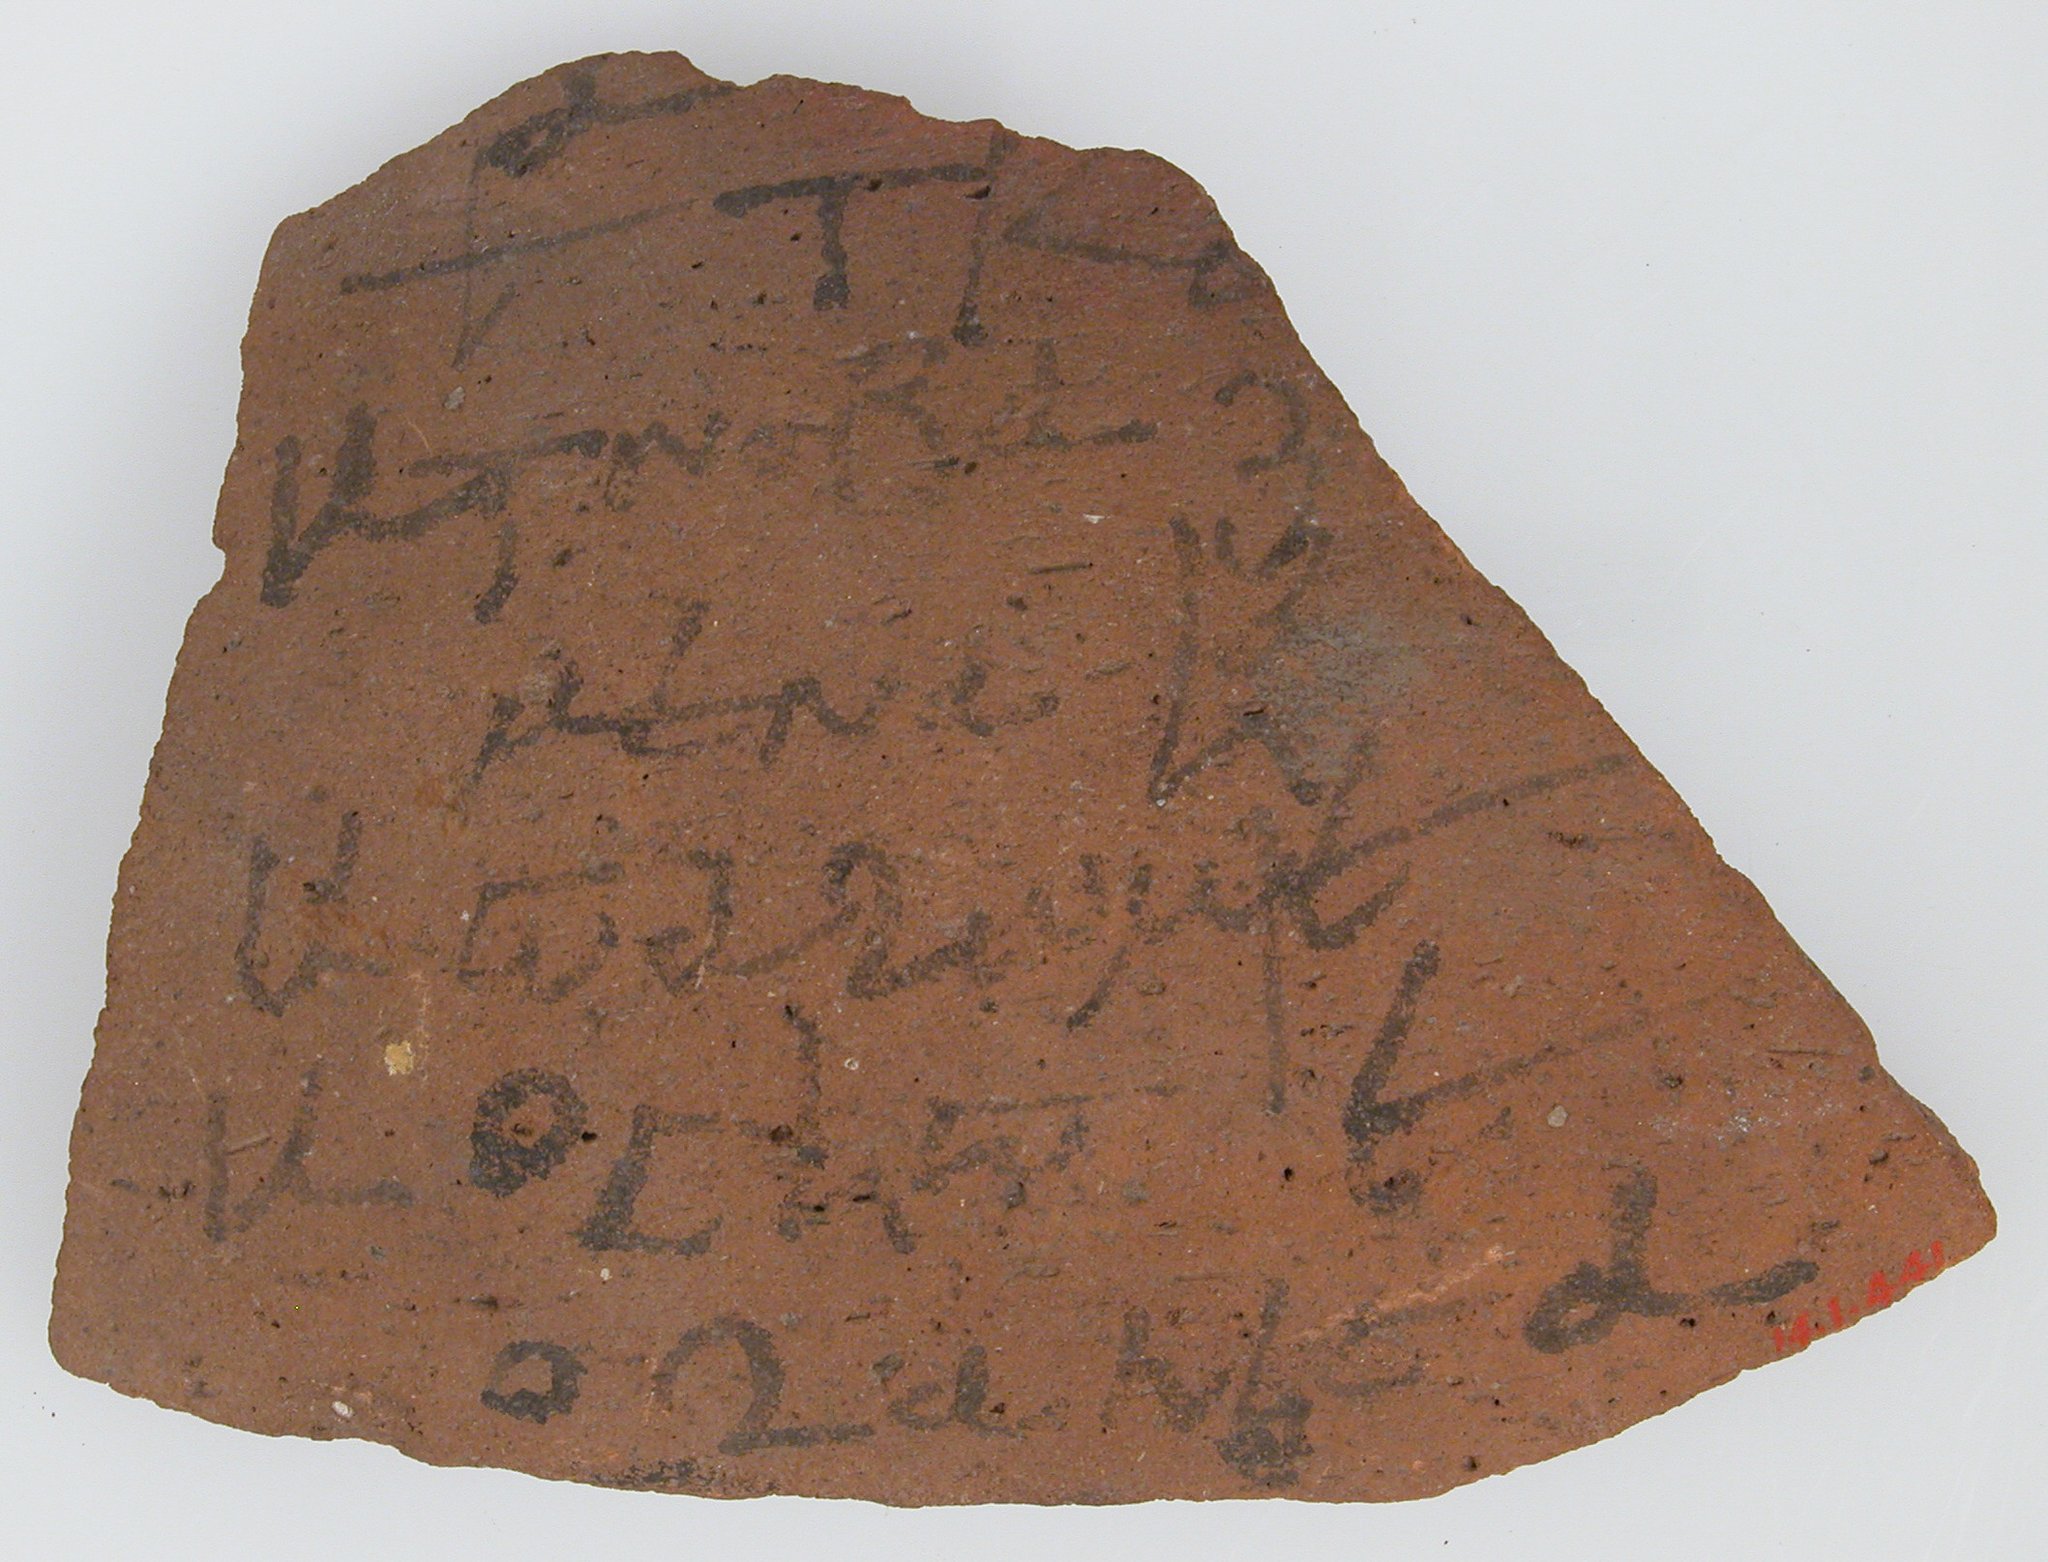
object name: ostrakon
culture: coptic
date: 580-640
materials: ink, pottery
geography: egypt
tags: coptic,documents